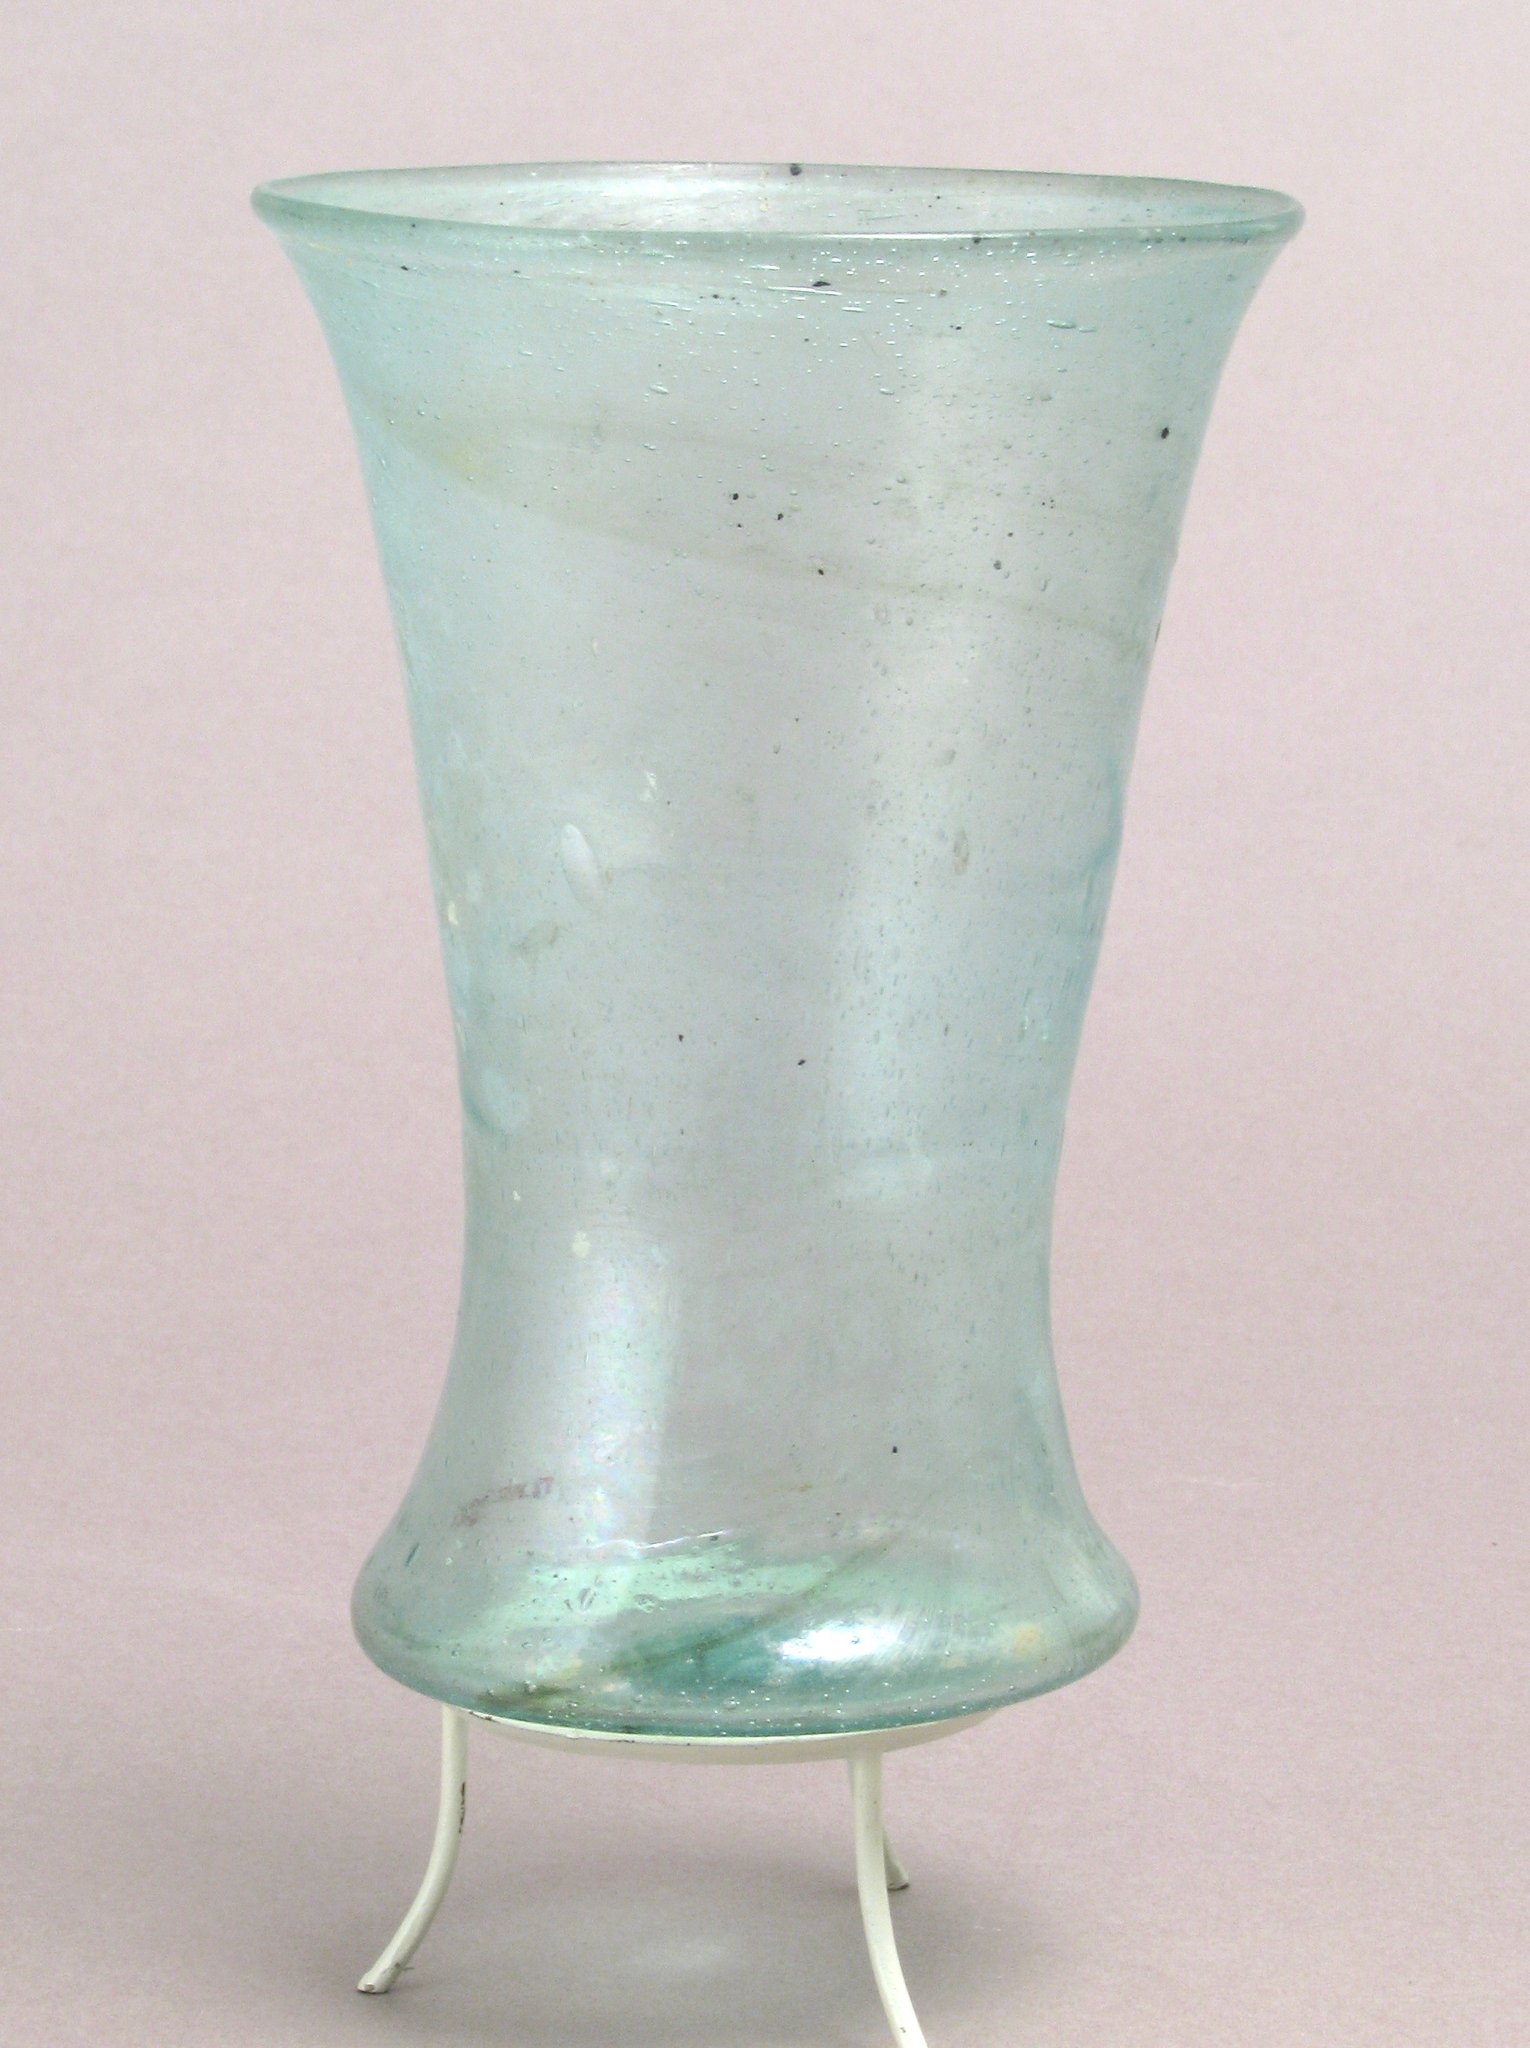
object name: beaker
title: Bell Beaker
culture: frankish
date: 501-700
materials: glass